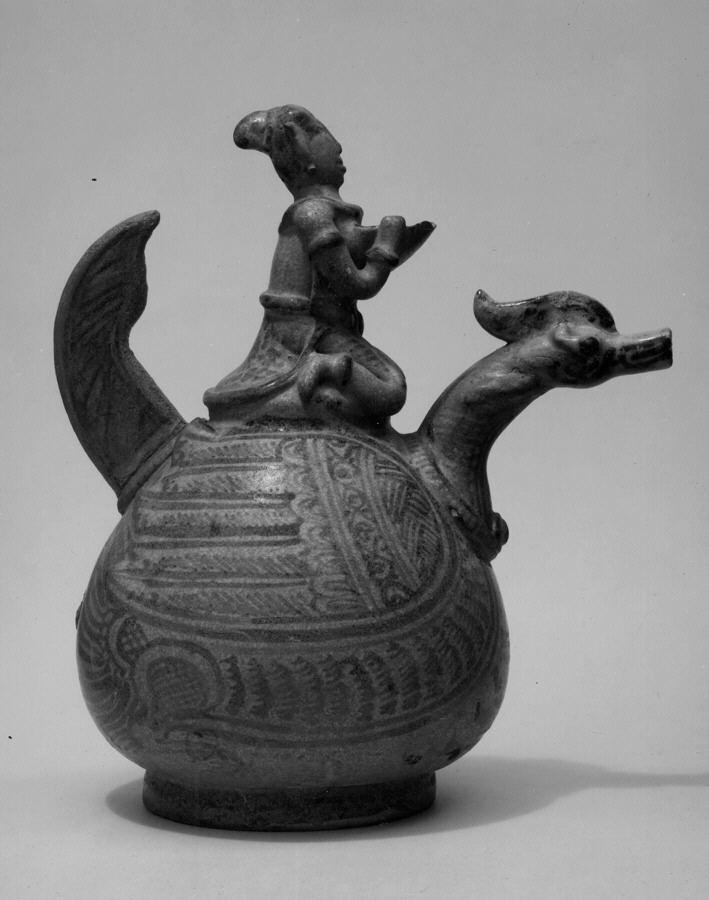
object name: vessel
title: Vessel with Swan and Male Rider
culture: thailand, sukhothai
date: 1301-1500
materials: earthenware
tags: men,swans